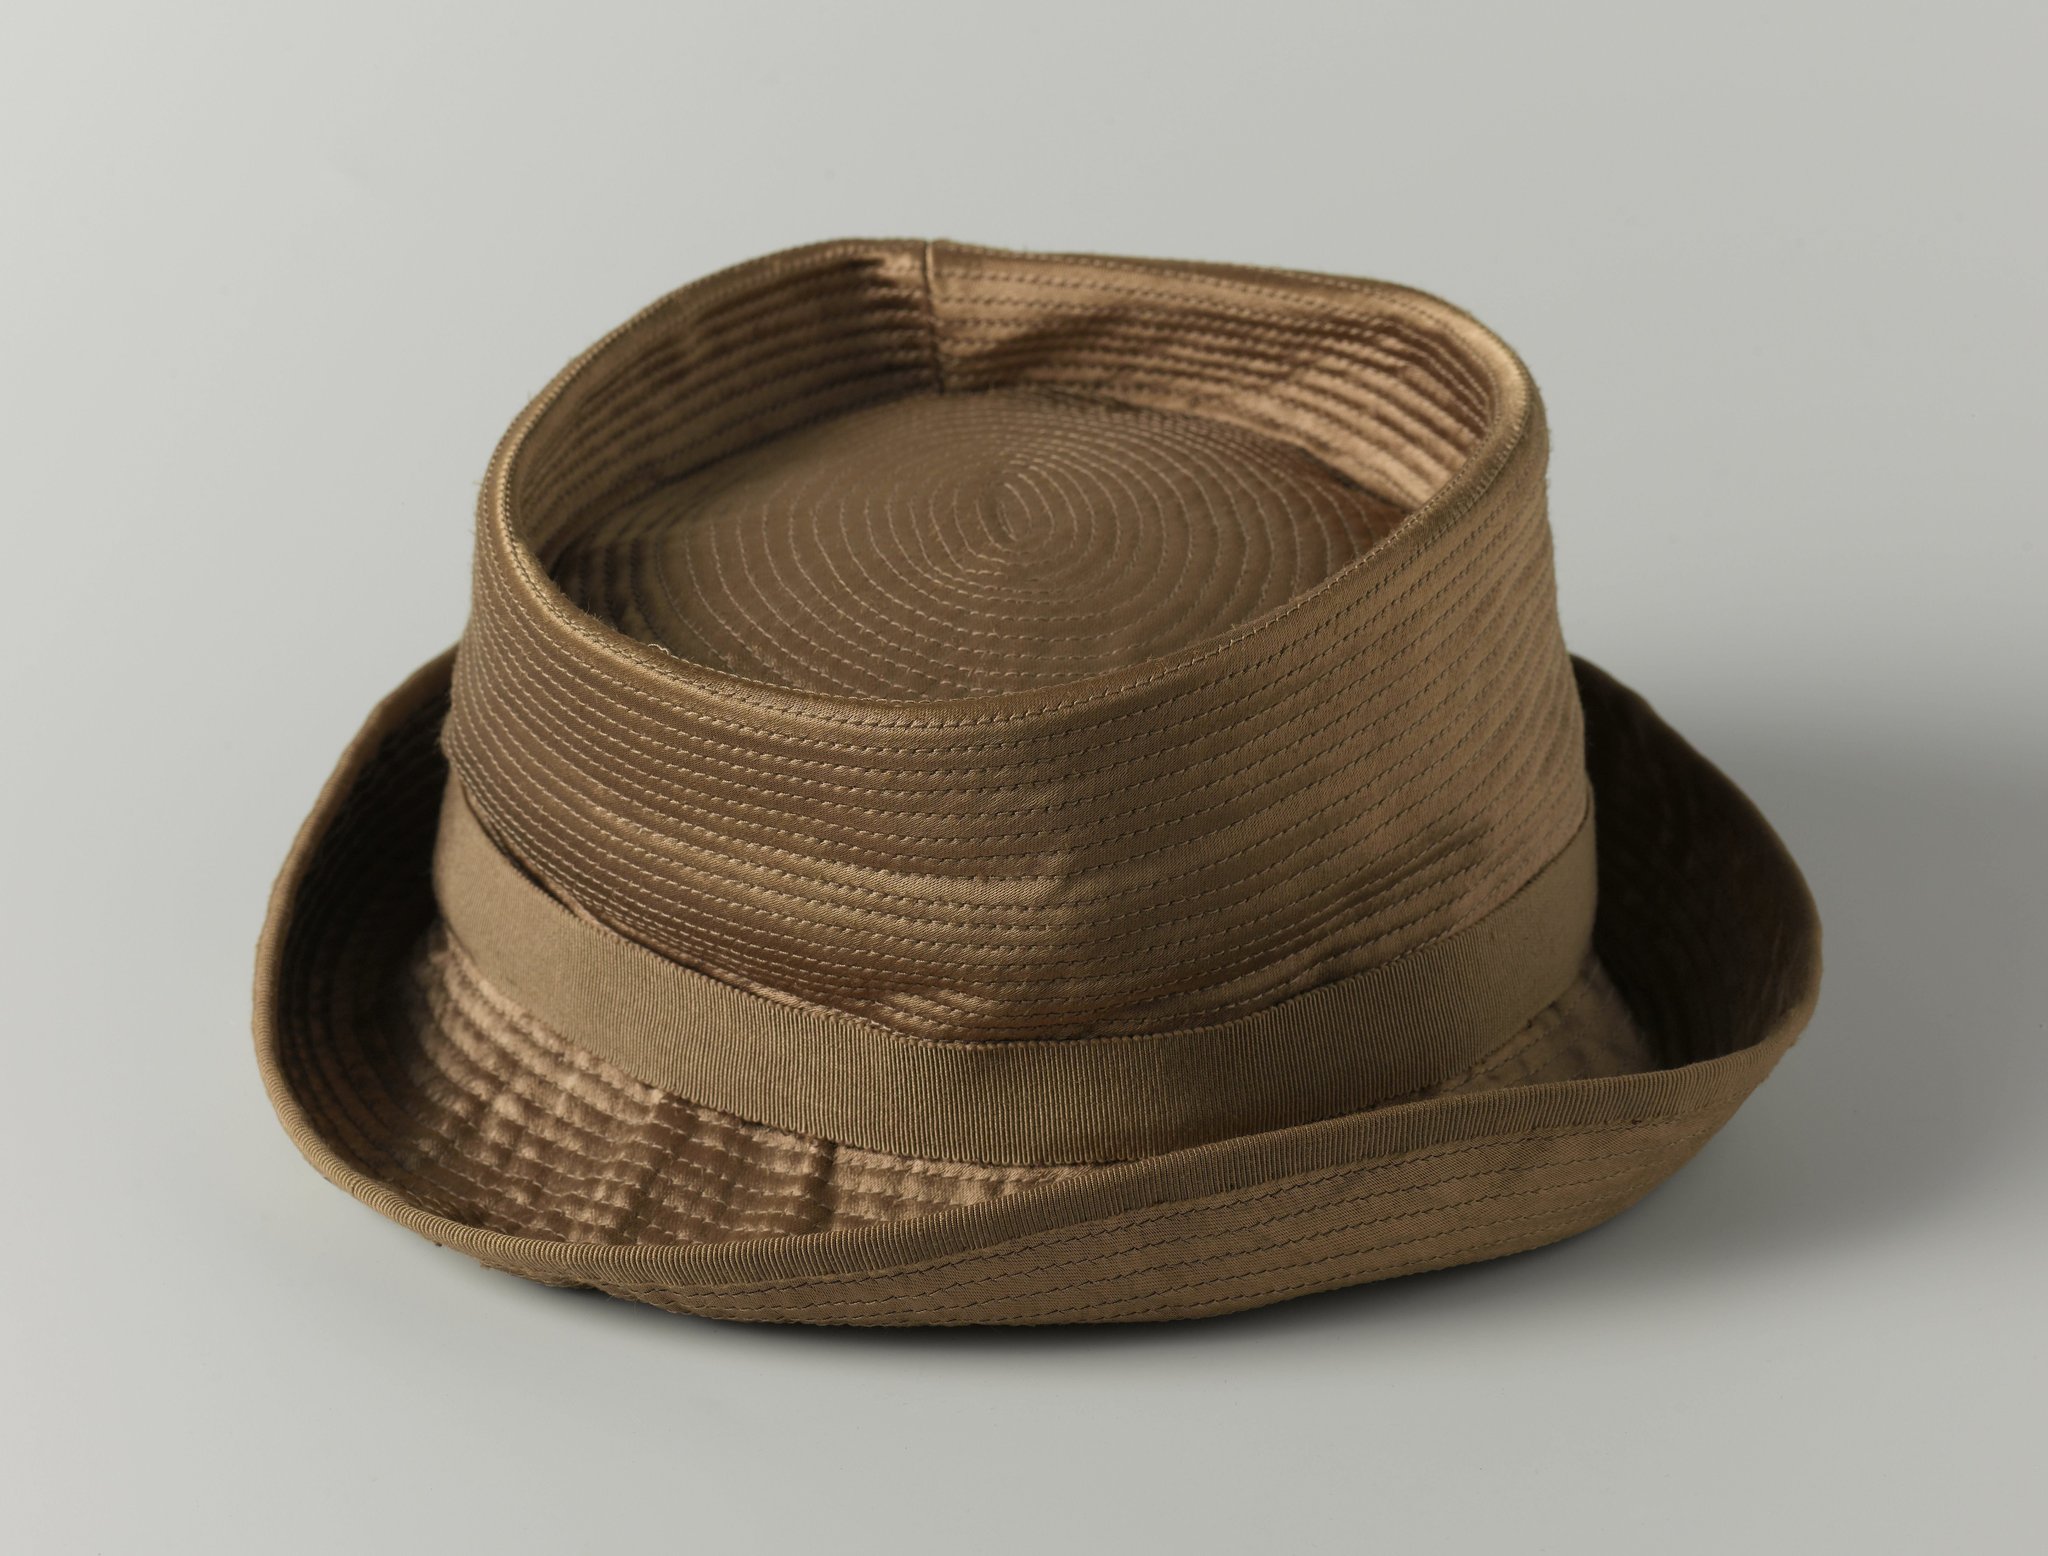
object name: womenswear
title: Hoed van doorgestikt bruin/beige satijn met bruin grosgrain lint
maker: gérard albouy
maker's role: hoedenmaker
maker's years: 1912-1985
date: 1945-1955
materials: textile, silk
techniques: quilting, weave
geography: paris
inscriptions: name: ‘Albouy/ 49 Rue du Colisée/ Paris’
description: Hoed van doorgestikt bruin/beige satijn met bruin grosgrain lint. Model: losse bol en rand. Verzonken bol in 5 cm hoge opstaande rand. De hoedrand is afgezet met bruin/beige grosgrain, hetzelfde als het band op de naad van bol en rand, middenachter eindigend in een platte strik. Gevoerd met beige kunstzijde. Donkerbruine hoedband.